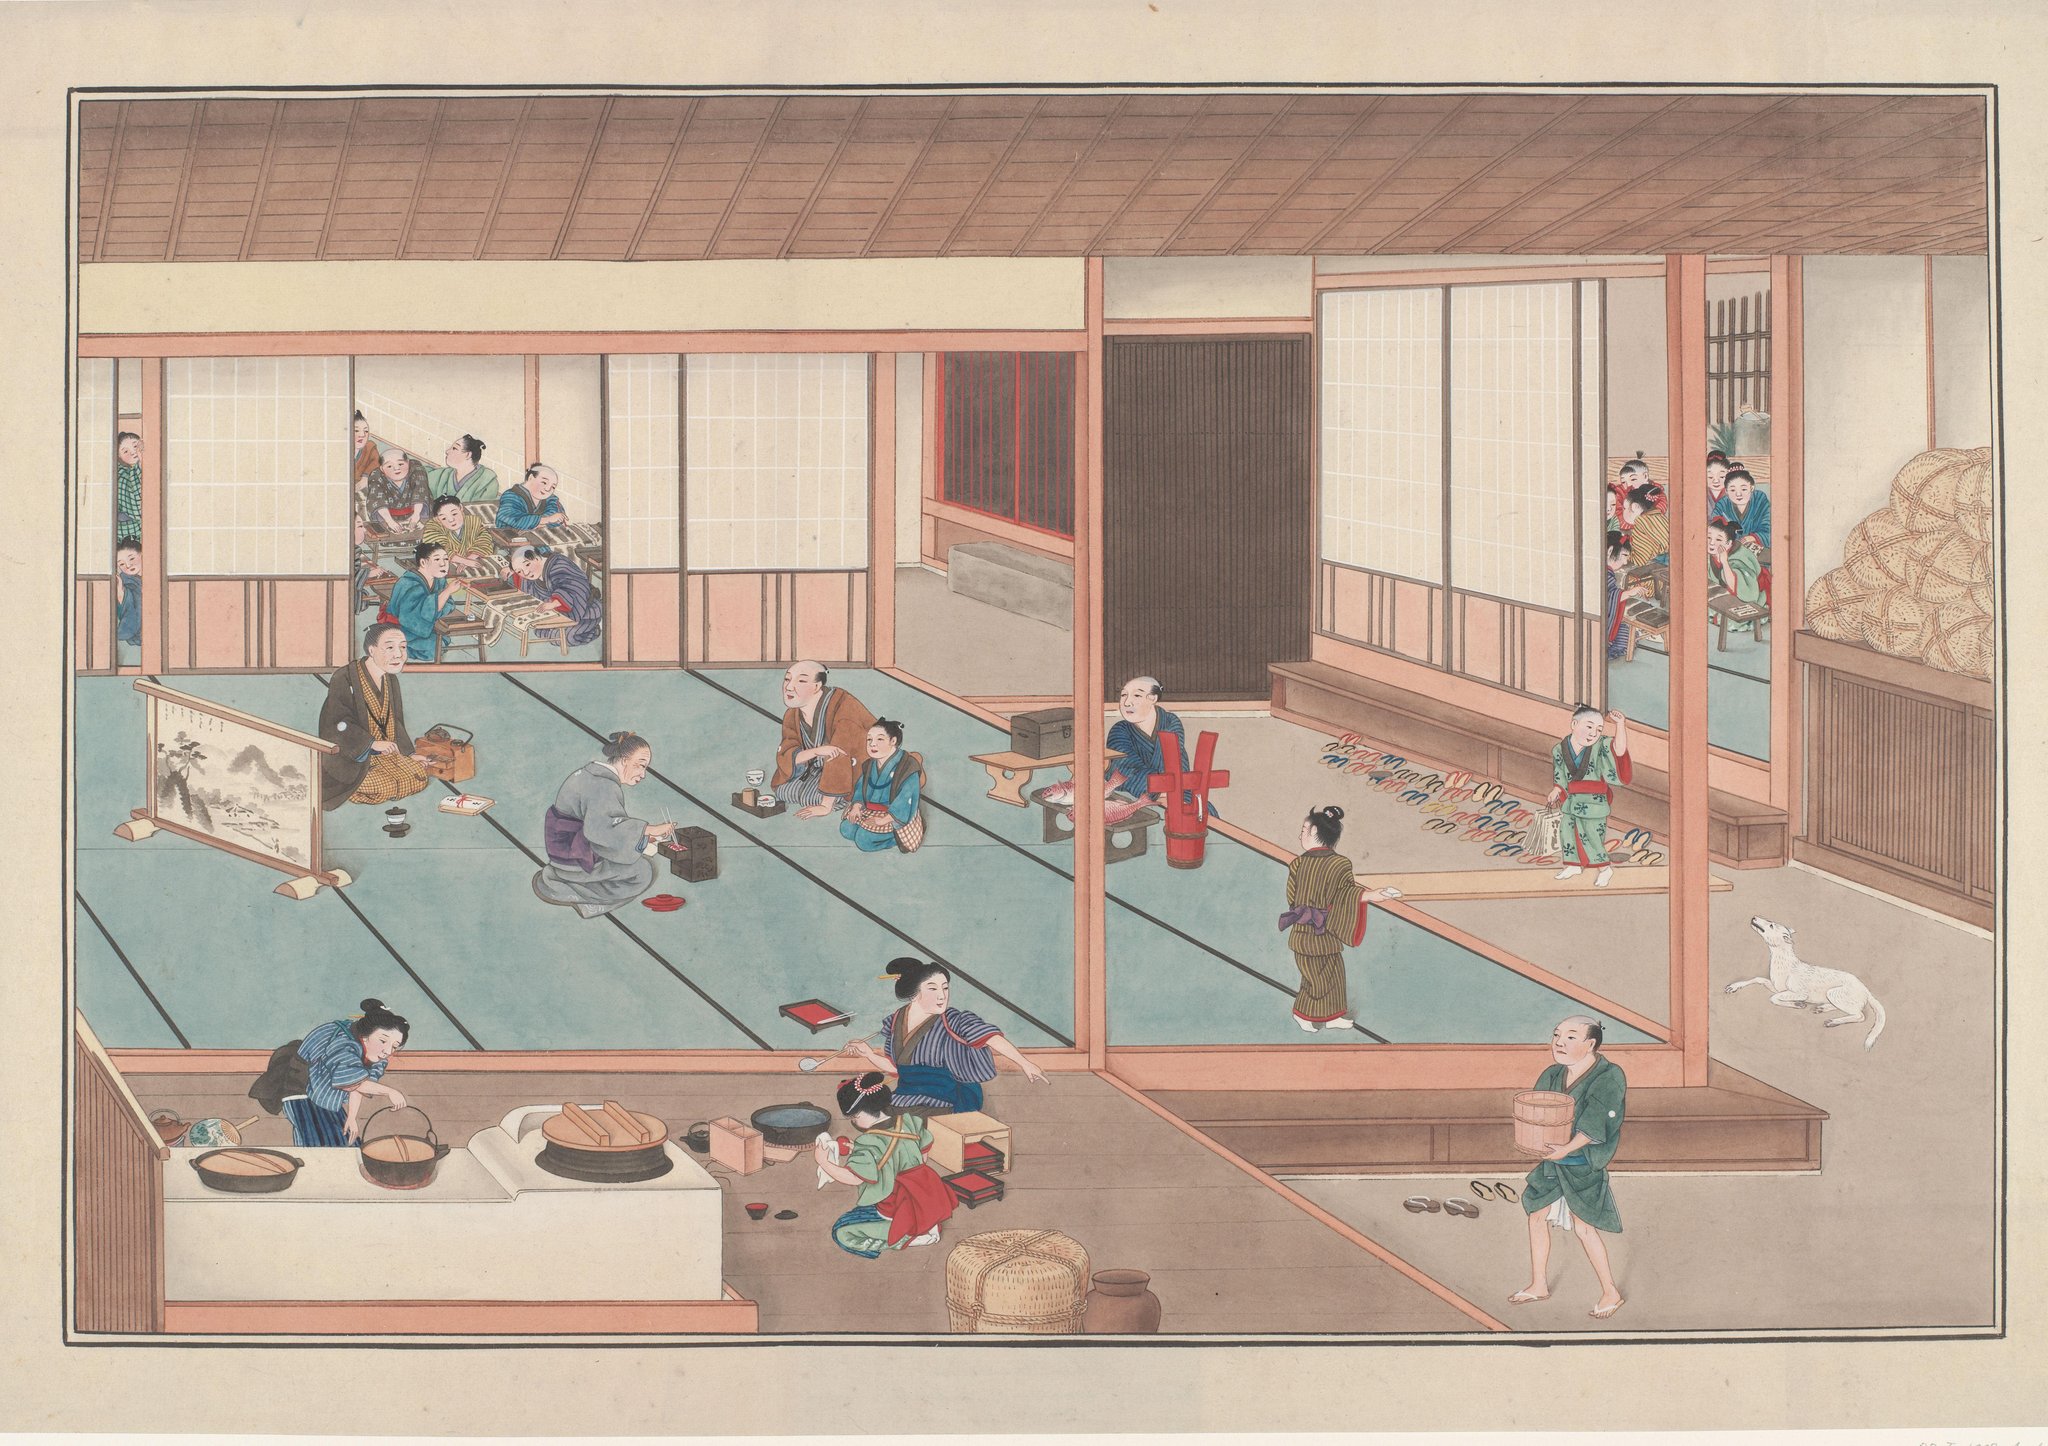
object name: drawing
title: Japanse kinderschool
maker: Anonymous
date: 1800-1900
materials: paper, watercolor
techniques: brush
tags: nursery school, elementary school; class, form, japan